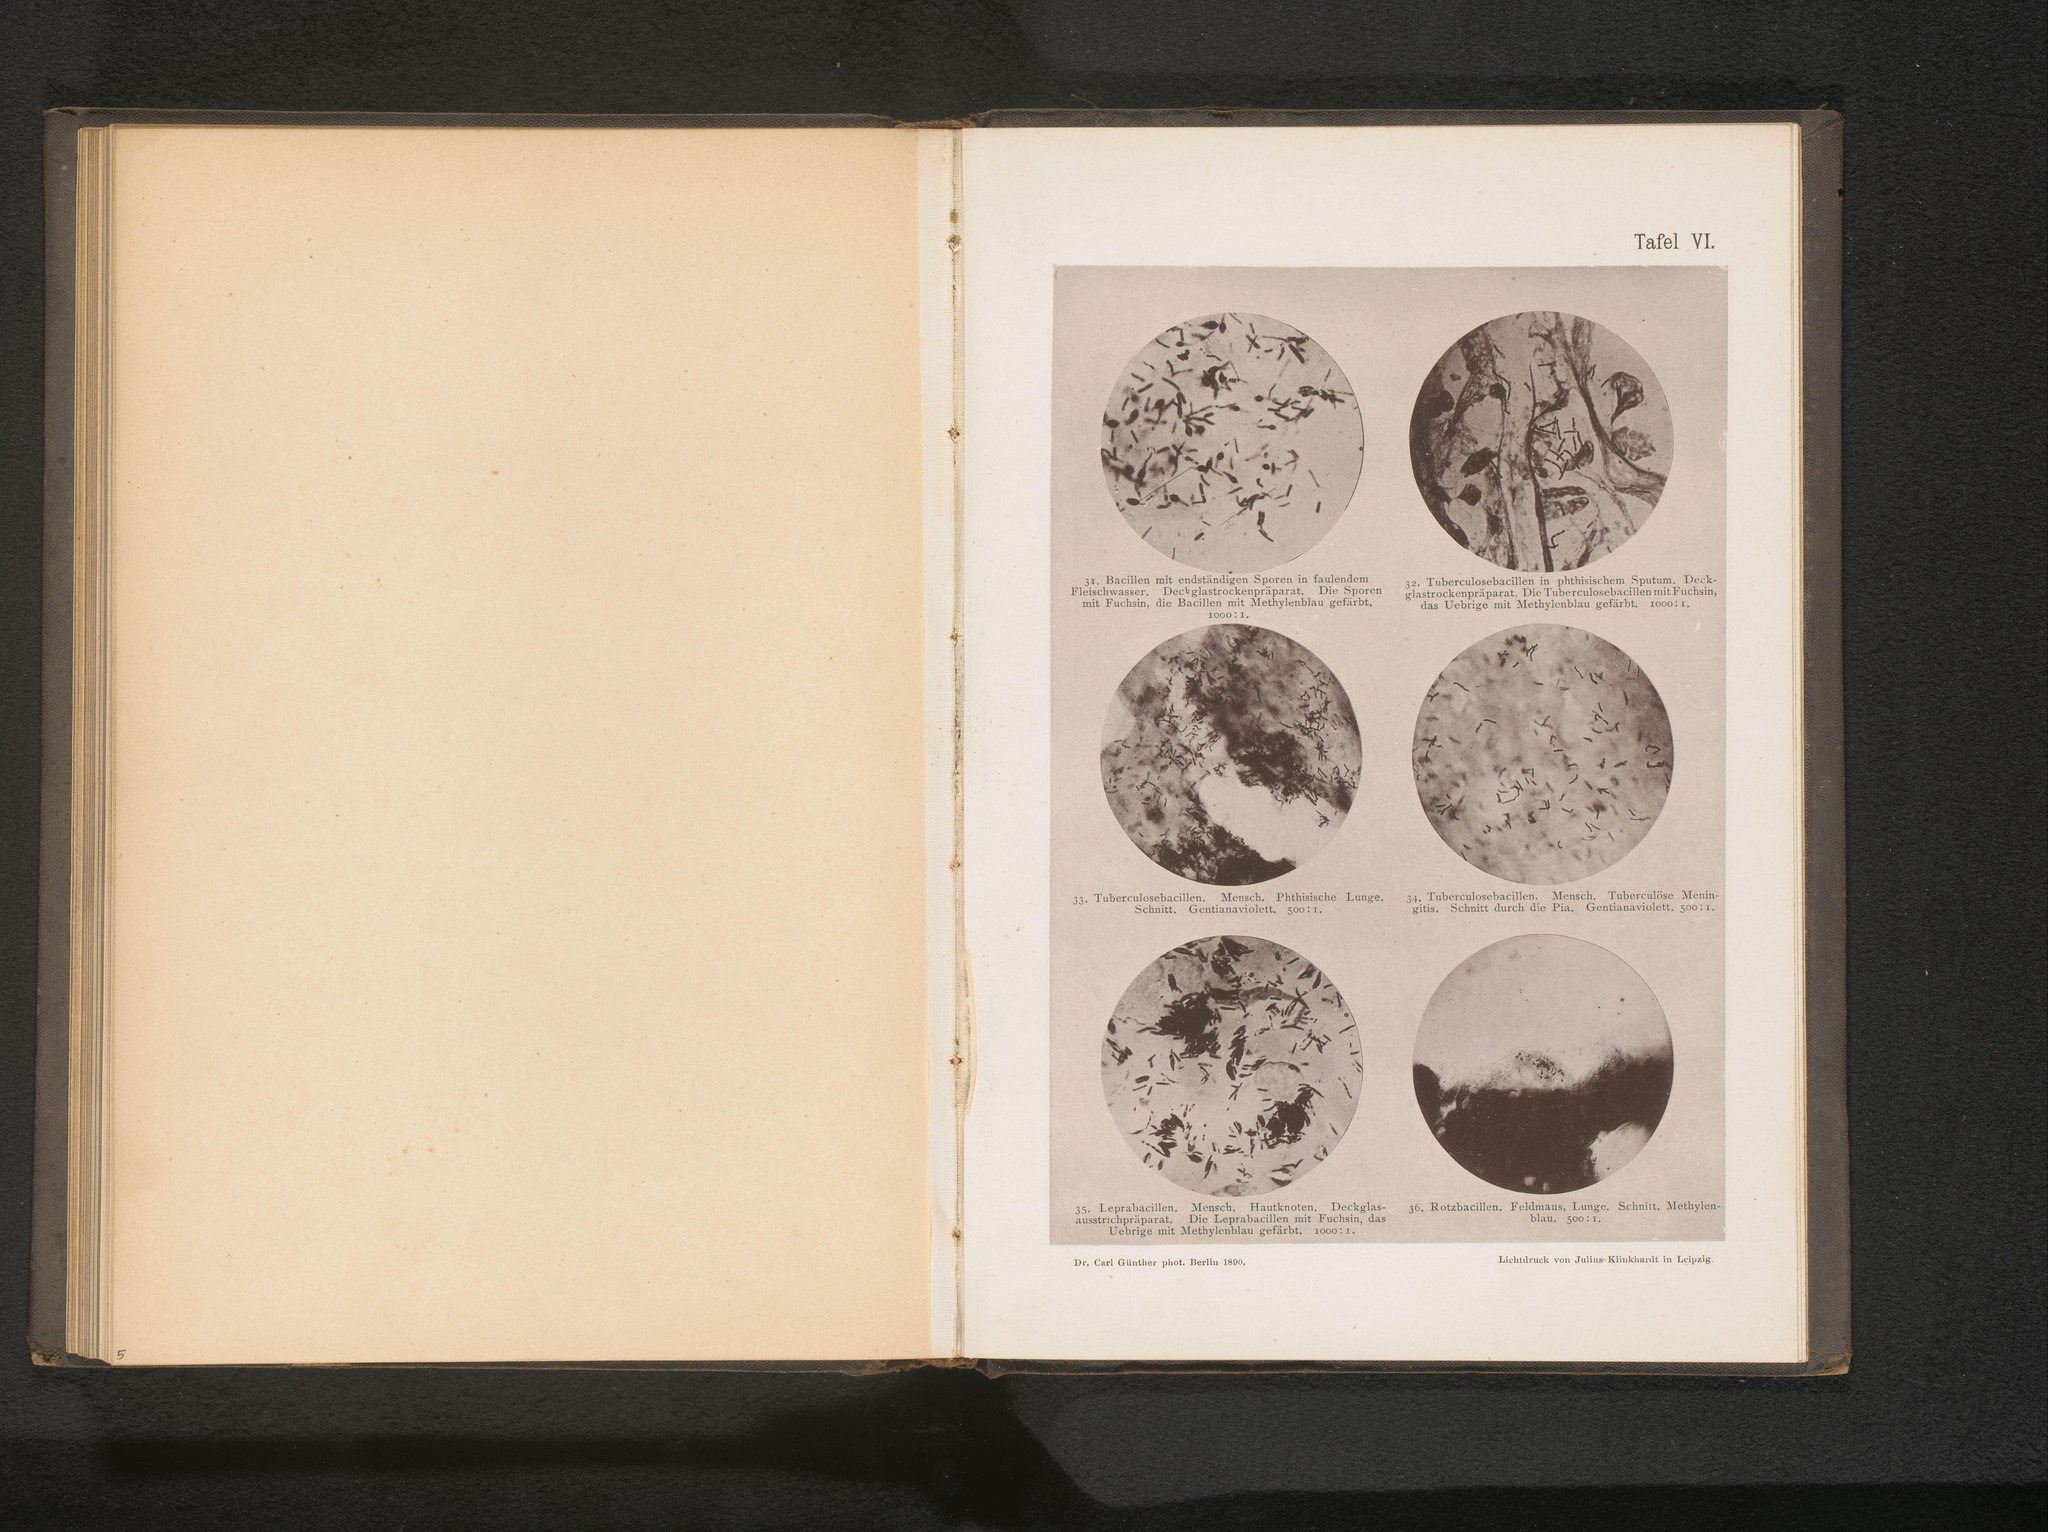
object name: photomechanical print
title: Zes microscoopopnamen van bacteriën, waaronder tuberculose en leprabacillen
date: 1880-1890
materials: paper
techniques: photograph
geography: berlin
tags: unicellular animals, bacteria, bacilli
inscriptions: inscription: ‘31. bacillen mit endstäandigen Sporen in faulendem Fleischwasser. Deckglastrockenpräparat. Die Sporen mit Fuchsin, die Bacillen mit Methylenblau gefärbt. 1000:1. 32. Tuberculosebacillen in phthisischem Sputum. Deckglastrockenpräparat. Die Tuberculosebacillen mit Fuchsin, das Uebrige mit Methylenblau gefärbt. 1000:1. 33. Tuberculosebacillen. Mensch. Phthisische Lunge. Schnitt. Gentianaviolett. 500:1. 34. Tuberculosebacillen. mensch. Tuberculöse Meningitis. Schnitt durch die Pia. Gentianaviolett. 500:1. 35. Leprabacillen. Mensch. Hautknoten. Deckglasausstichpräparat. Die Leprabacillen mit Fuchsin, das Uebrige mit Methylenblau gefärbt. 1000:1. 36. Rotzbacillen. Feldmaus, Lunge. Schnitt. Methylenblau. 500:1.’, number: ‘Tafel VI.’